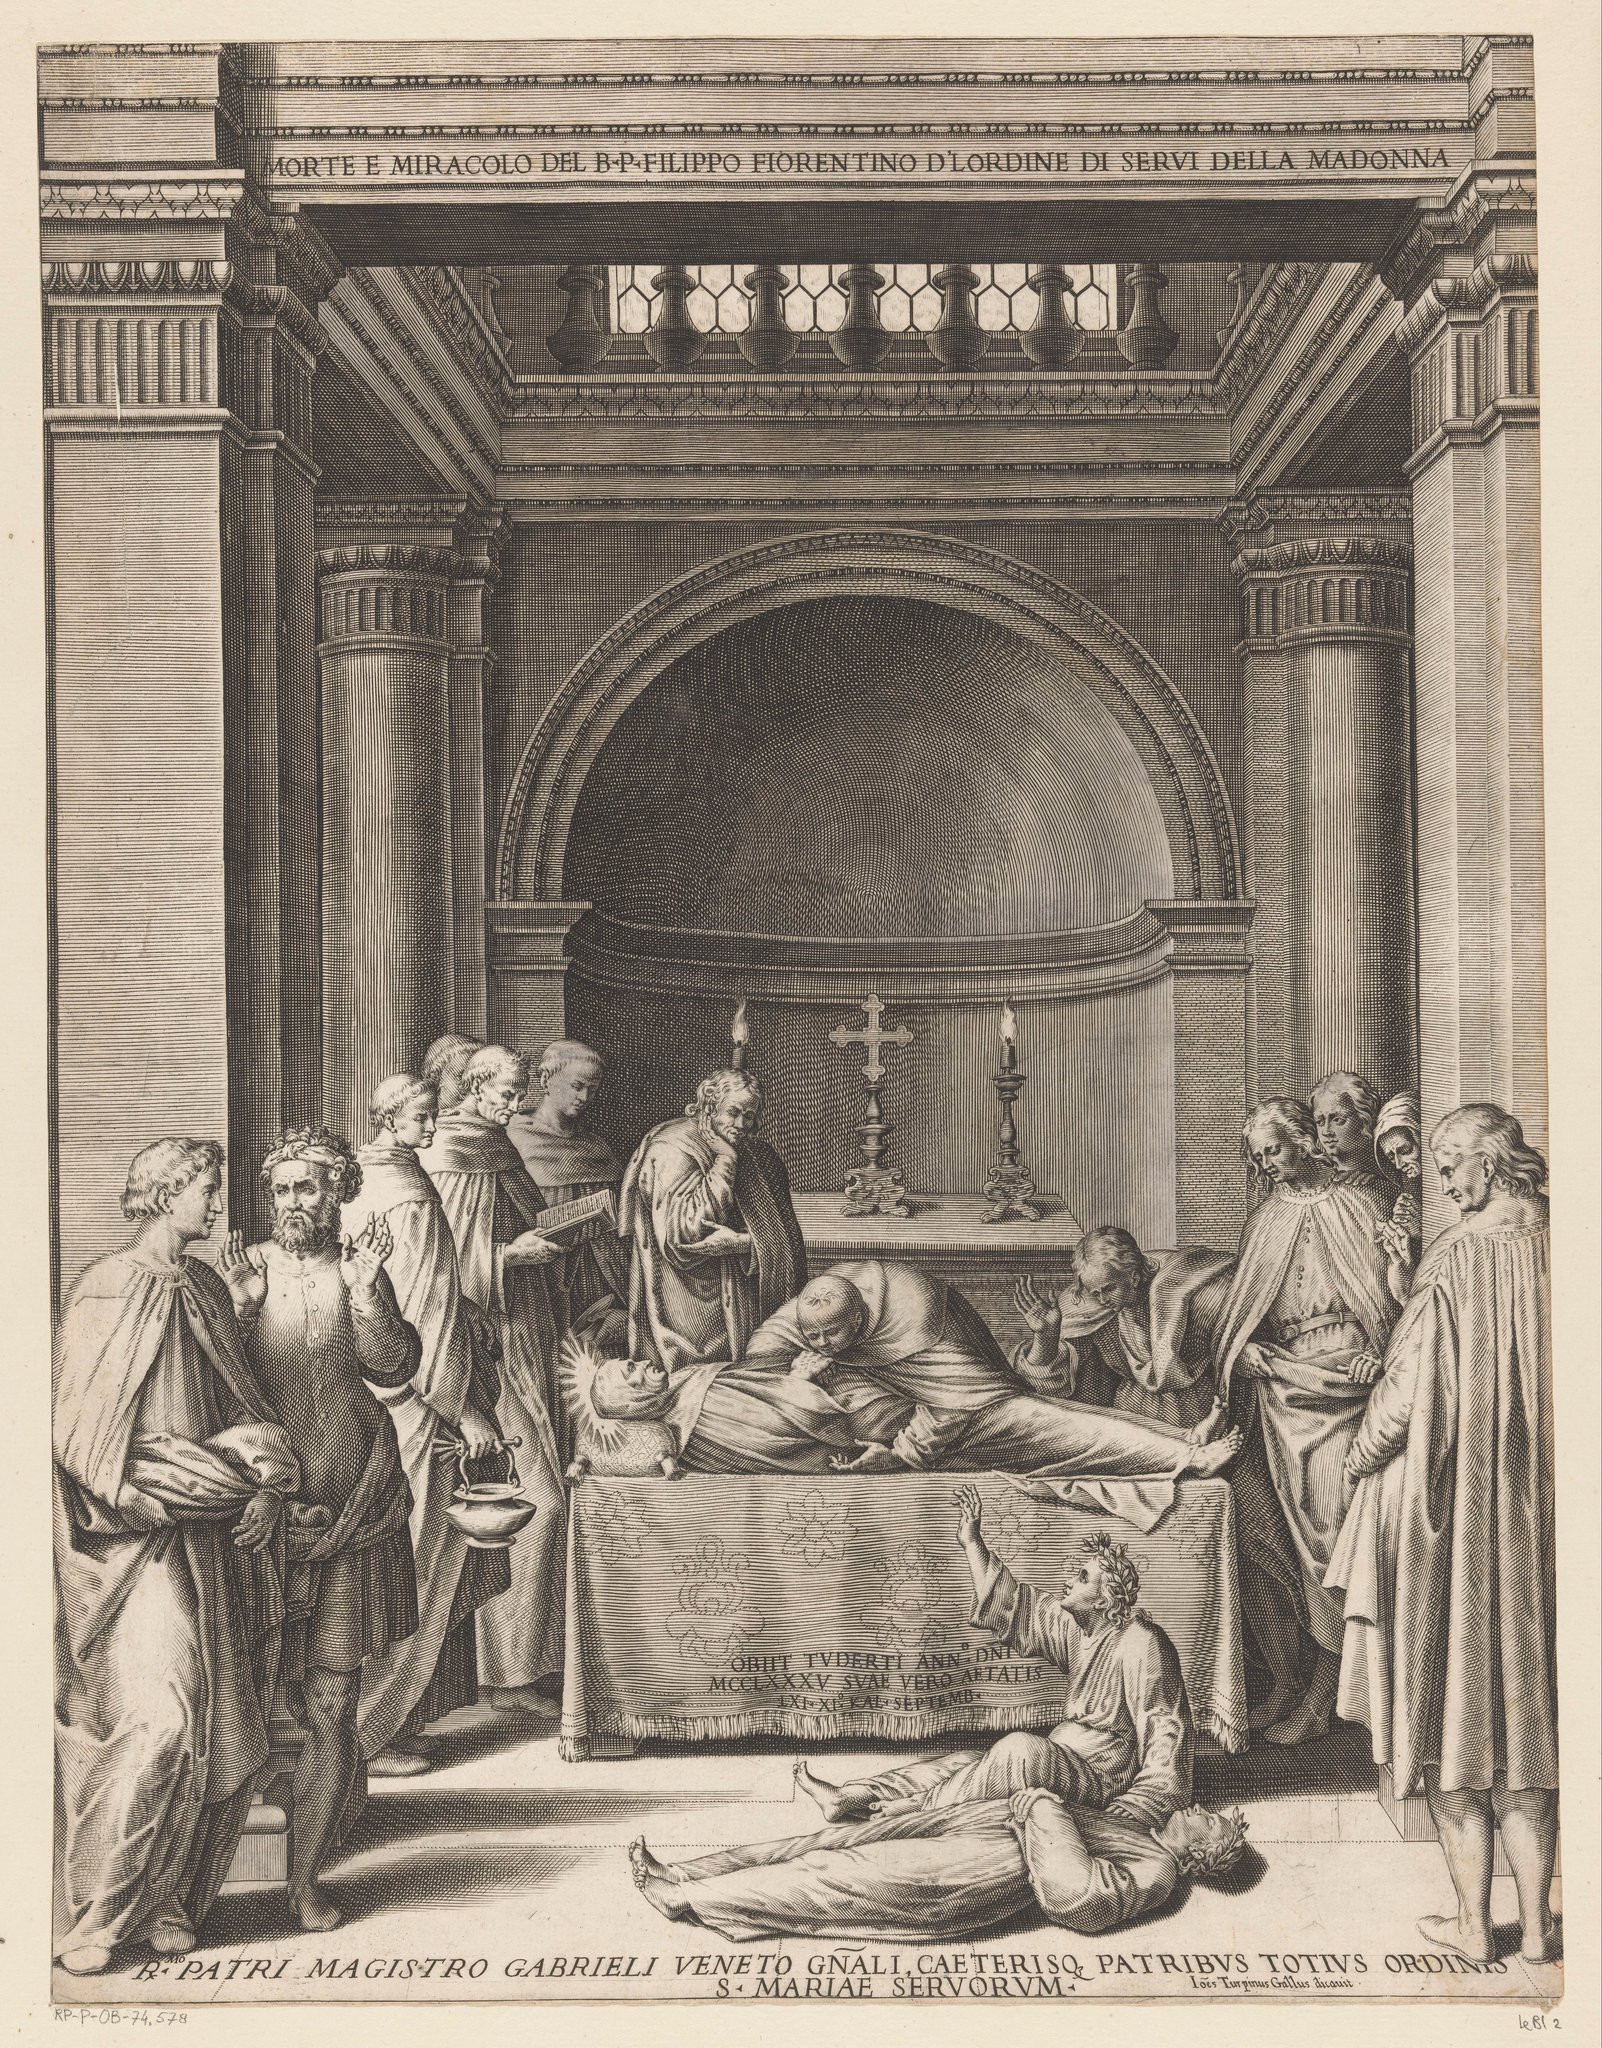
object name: print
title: Dood en wonder van Filippo Benizi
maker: jean turpin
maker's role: print maker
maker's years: 1561-1626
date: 1571-1626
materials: paper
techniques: engraving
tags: burial, male saints (with name) - posthumous deeds, appearances of male saints, death of human being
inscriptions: collector's mark: Lugt 240, number: ‘4.4.-77.’, number: ‘572’